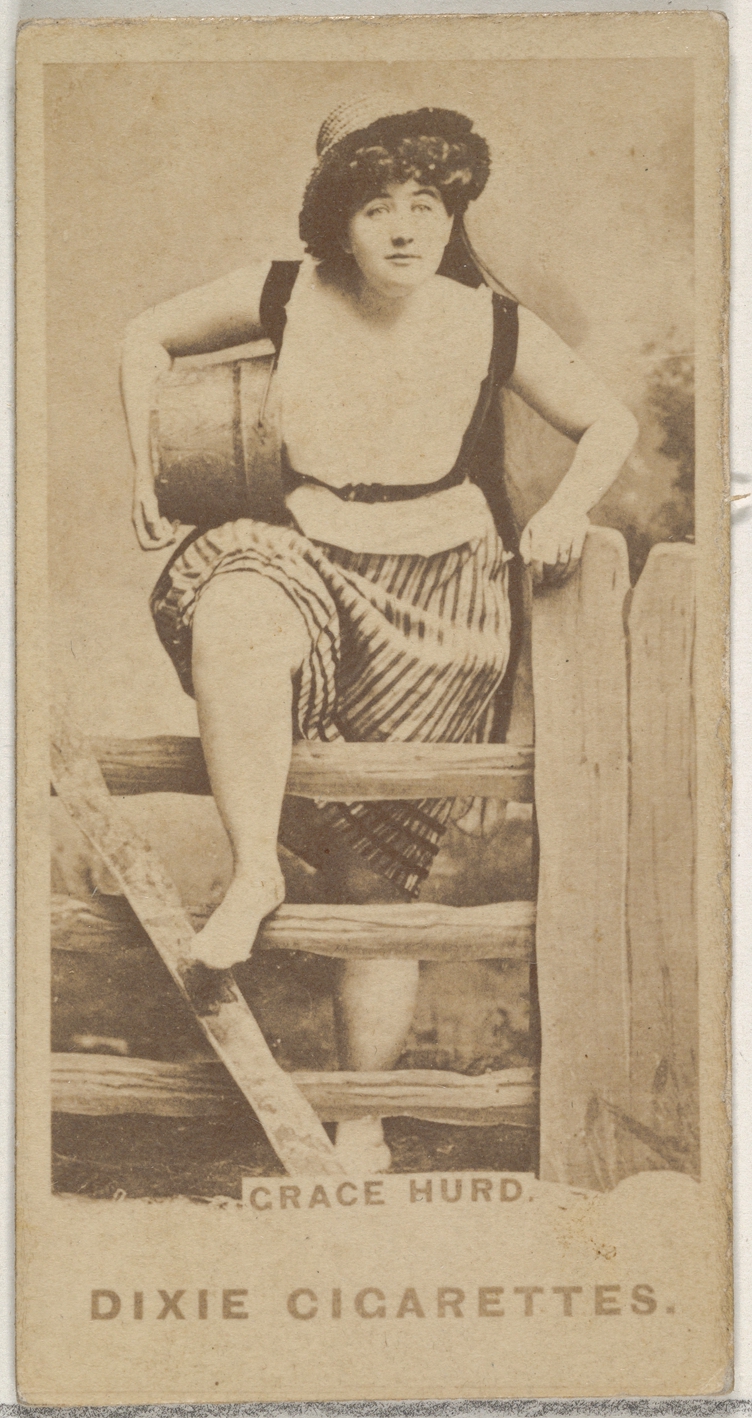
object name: photograph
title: Grace Hurd, from the Actors and Actresses series (N45, Type 7) for Dixie Cigarettes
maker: allen & ginter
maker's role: publisher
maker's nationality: american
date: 1888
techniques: albumen silver print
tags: portraits,women,actresses